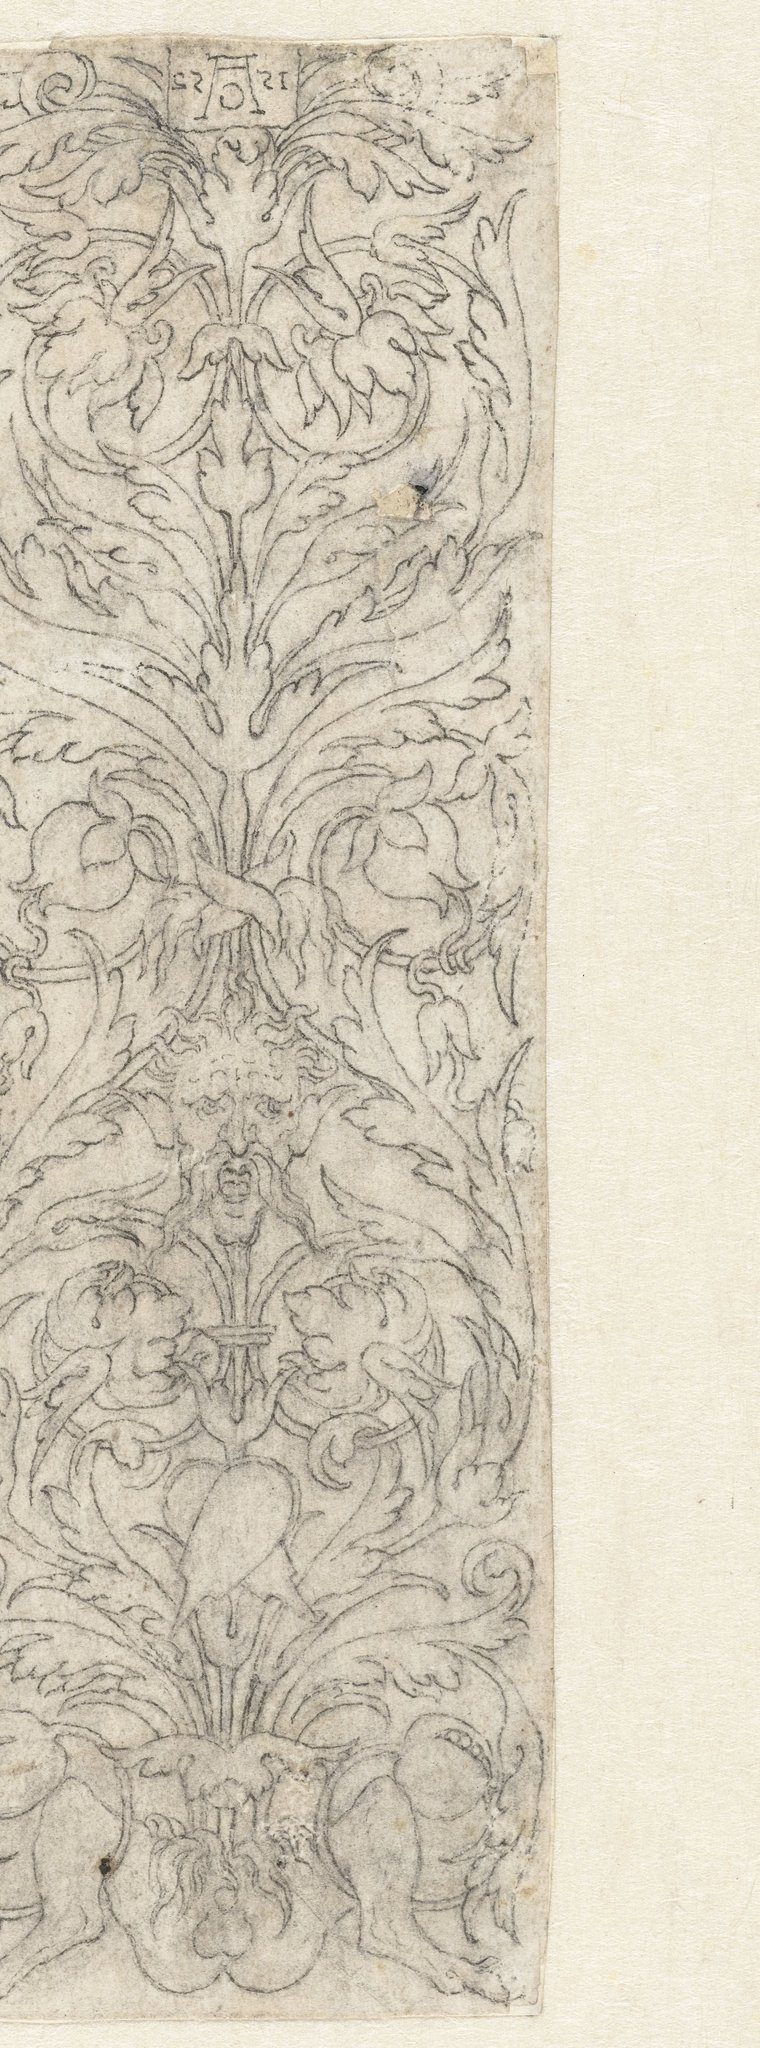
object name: ornamenttekening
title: Faun tussen bladornamenten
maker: heinrich aldegrever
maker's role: draughtsman, print maker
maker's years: 1502-1561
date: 1552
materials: ink, paper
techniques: pen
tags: mask, mascaron ~ ornament, ornament derived from plant forms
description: Bladornamenten ontspruitend uit het onderlijf van een faun, wiens kop in het midden van de voorstelling is afgebeeld. Ontwerp voor een prent.